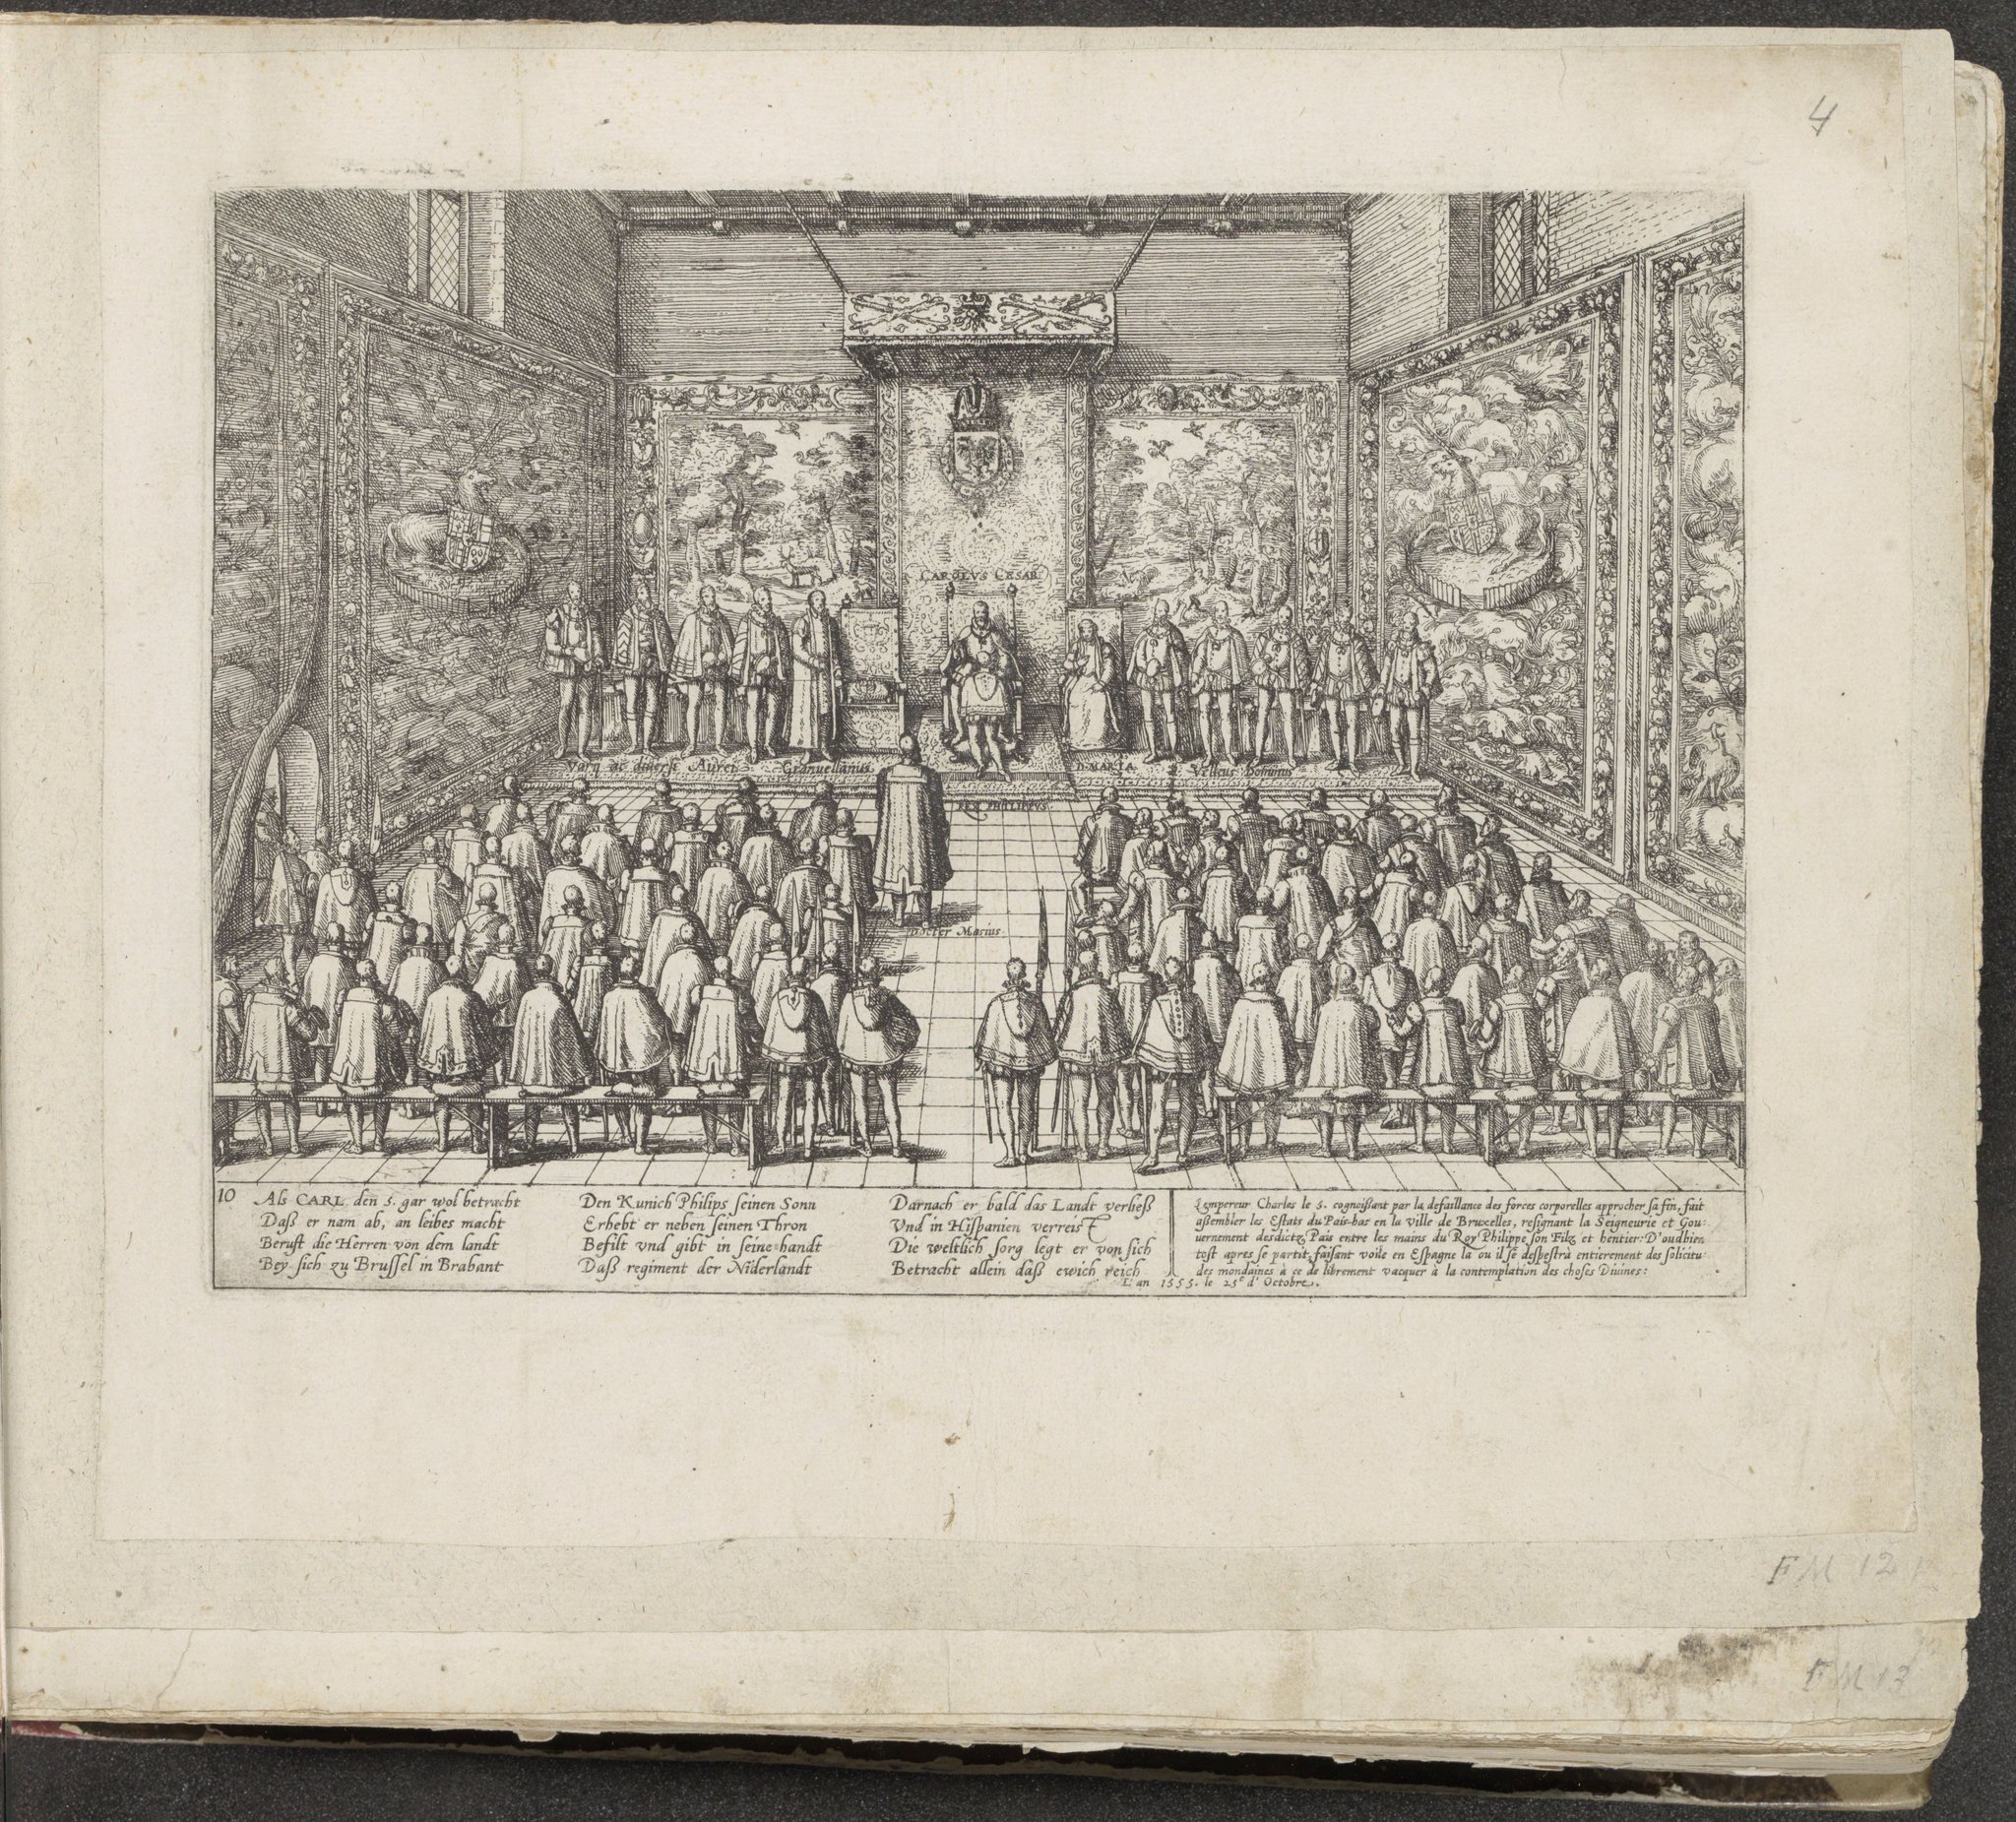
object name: print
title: Troonsafstand van keizer Karel V, 1555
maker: frans hogenberg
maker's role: print maker, publisher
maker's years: 1538-1590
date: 1568-1572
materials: paper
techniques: etching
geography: cologne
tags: philip ii of spain, antoine perrenot de granvelle, ghent, charles v (holy roman emperor and king of spain), voluntary abdication (of a ruler)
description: Karel V doet afstand van de troon, 25 oktober 1555. In de troonzaal knielt Filips voor zijn vader. Links Granvelle, rechts Margaretha van Parma en vliesridders. Ten overstaan van de volledige vergadering van de Staten-Generaal staande voor houten banken met kussens. De muren versierd met wandtapijten. Met onderschrift van 12 regels in het Duits en 5 regels in het Frans. Linksonder genummerd 10. De prent maakt deel uit van een album.